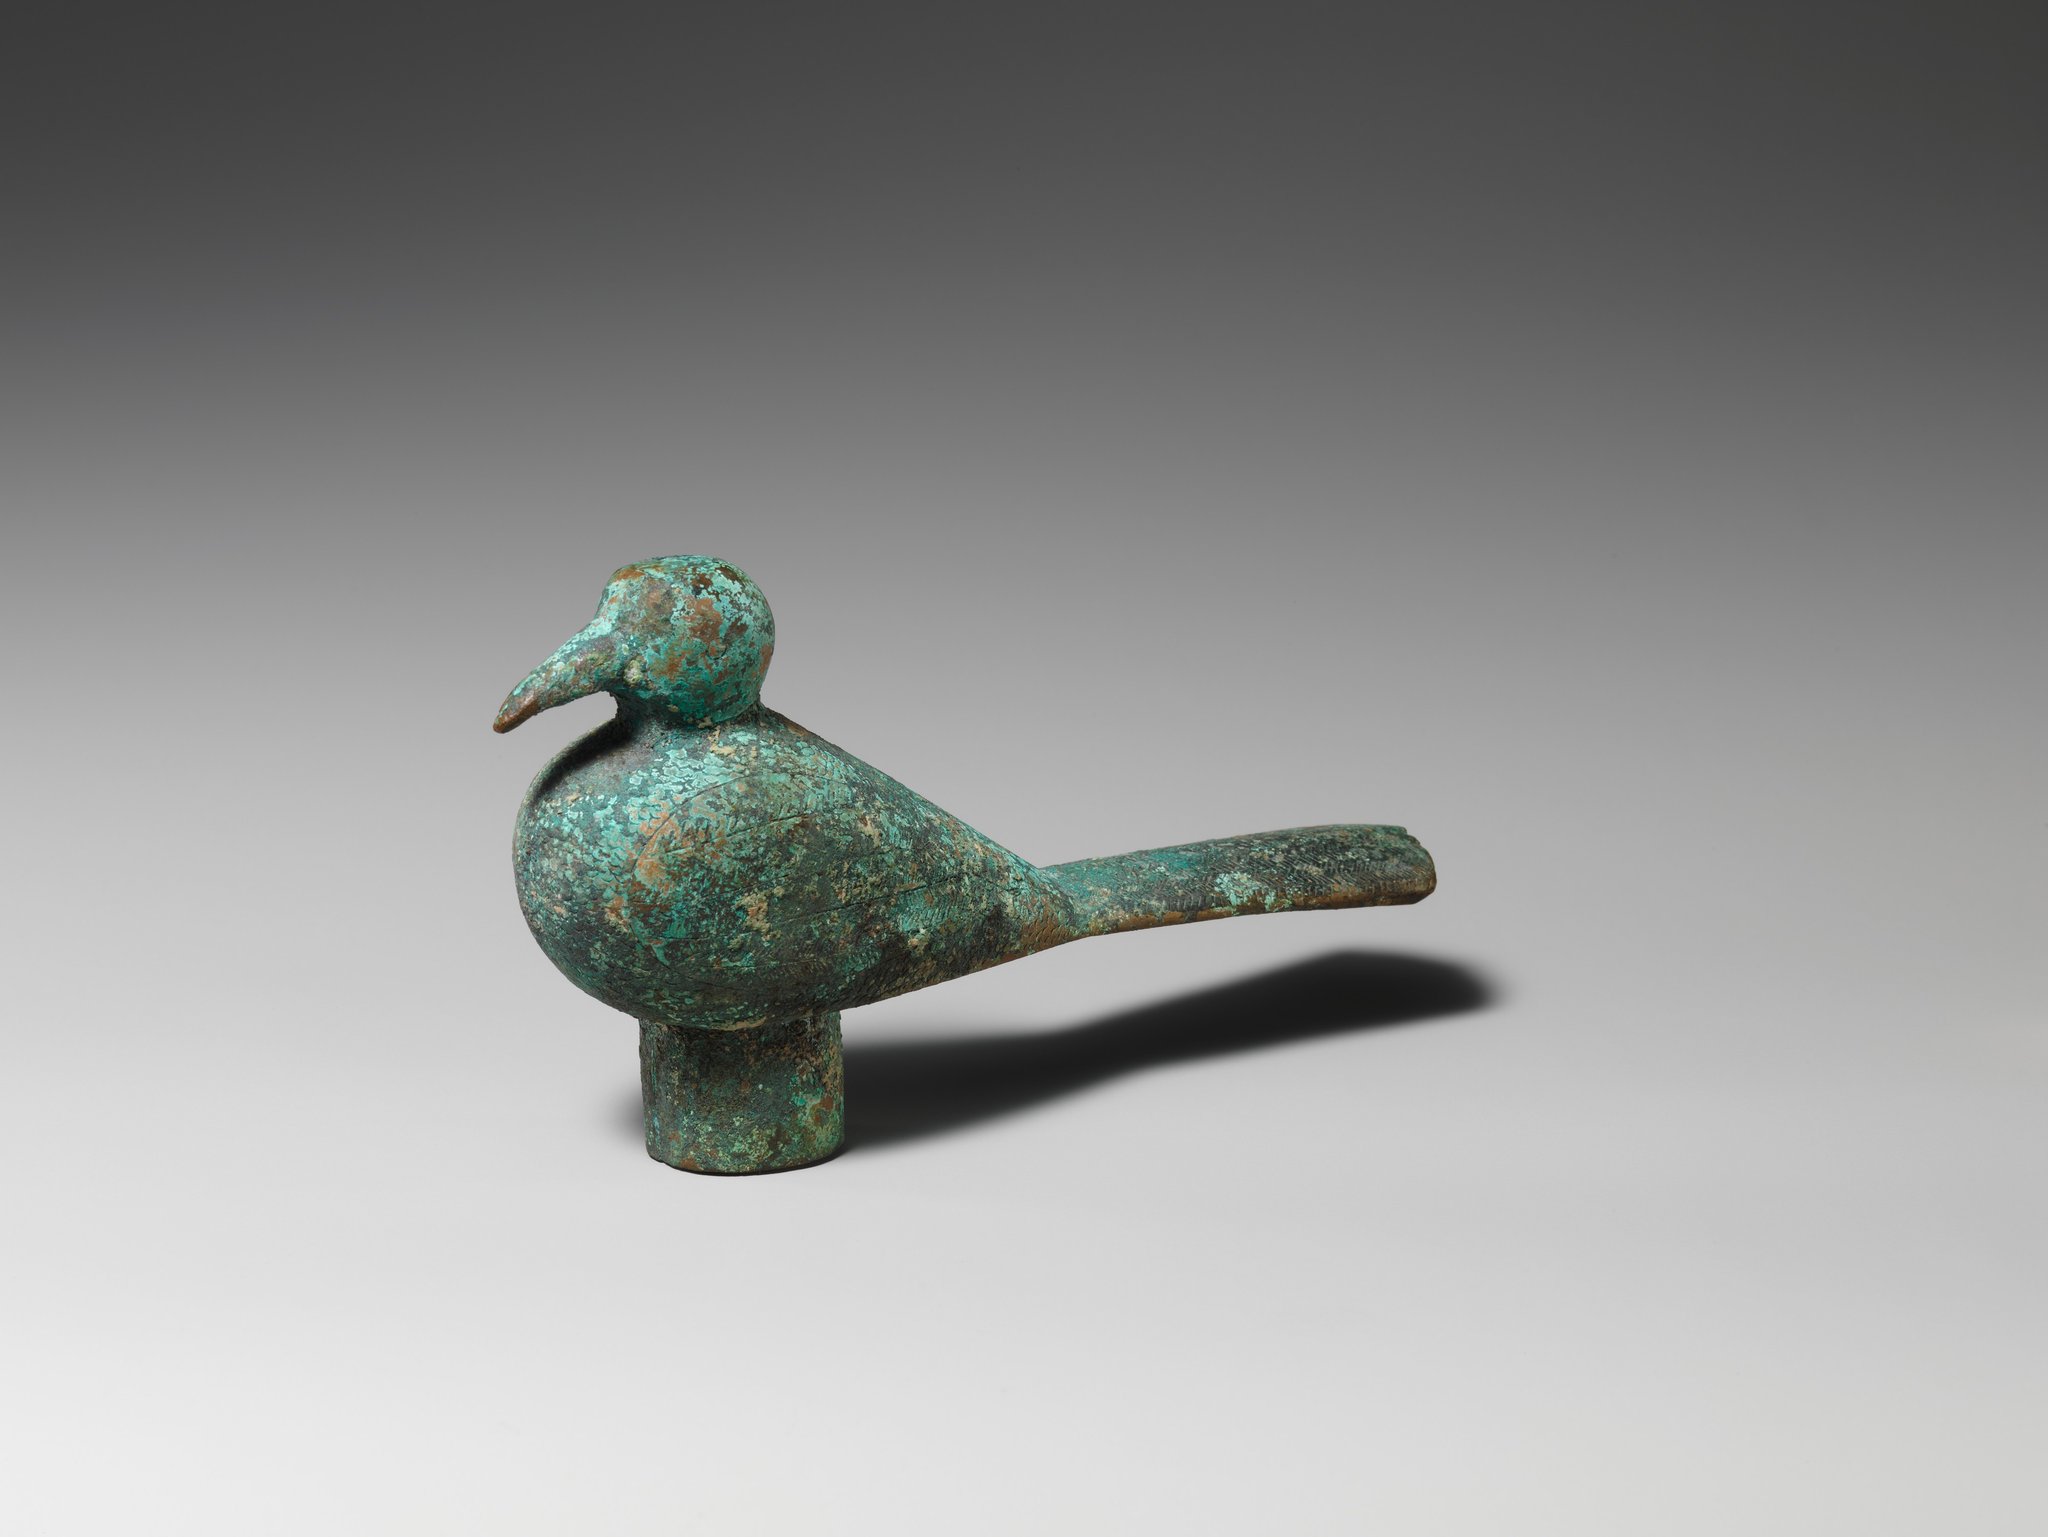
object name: finial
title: Bird-Shaped Finial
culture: chinese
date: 25-220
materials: bronze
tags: birds